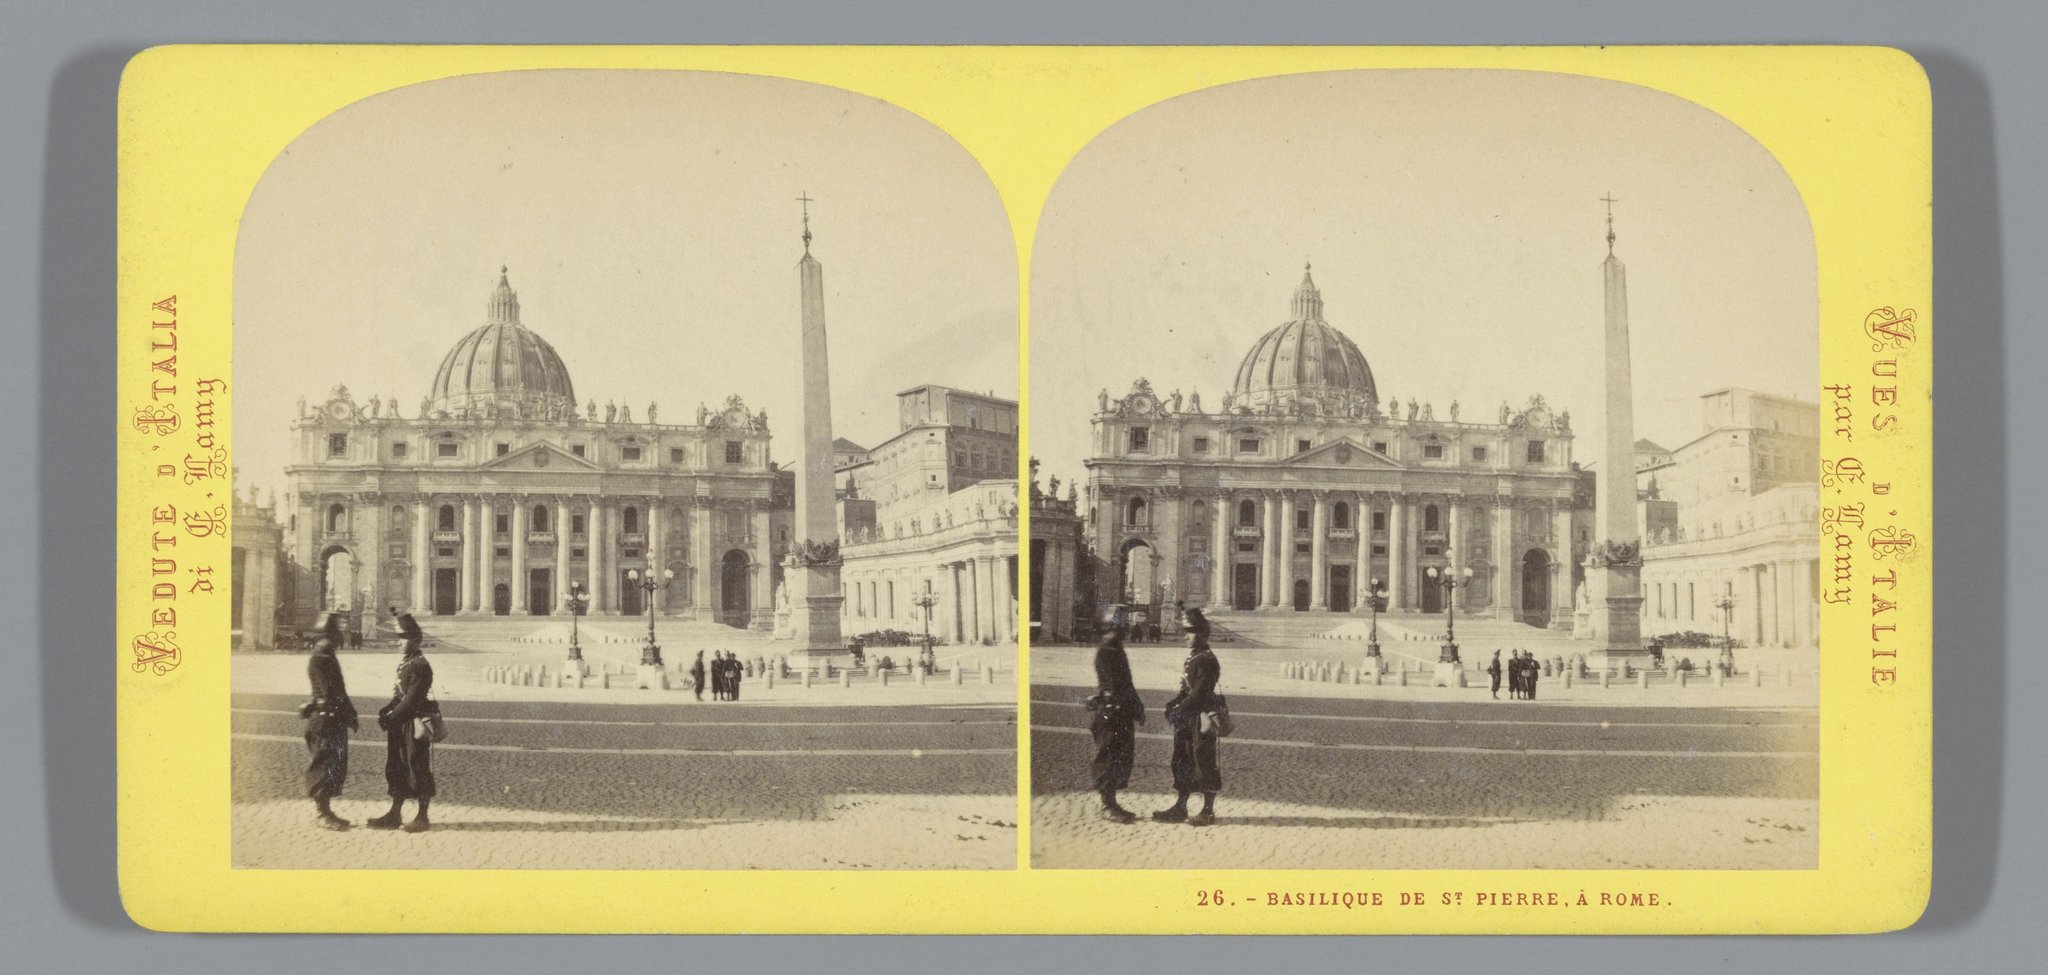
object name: stereograph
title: Vedute d'Italia / Vues d'Italie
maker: ernest eléonor pierre lamy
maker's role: publisher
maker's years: 1828-1900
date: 1861-1878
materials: cardboard, paper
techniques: albumen print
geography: vatican city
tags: obelisk, needle, church (exterior)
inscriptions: number: ‘26.’